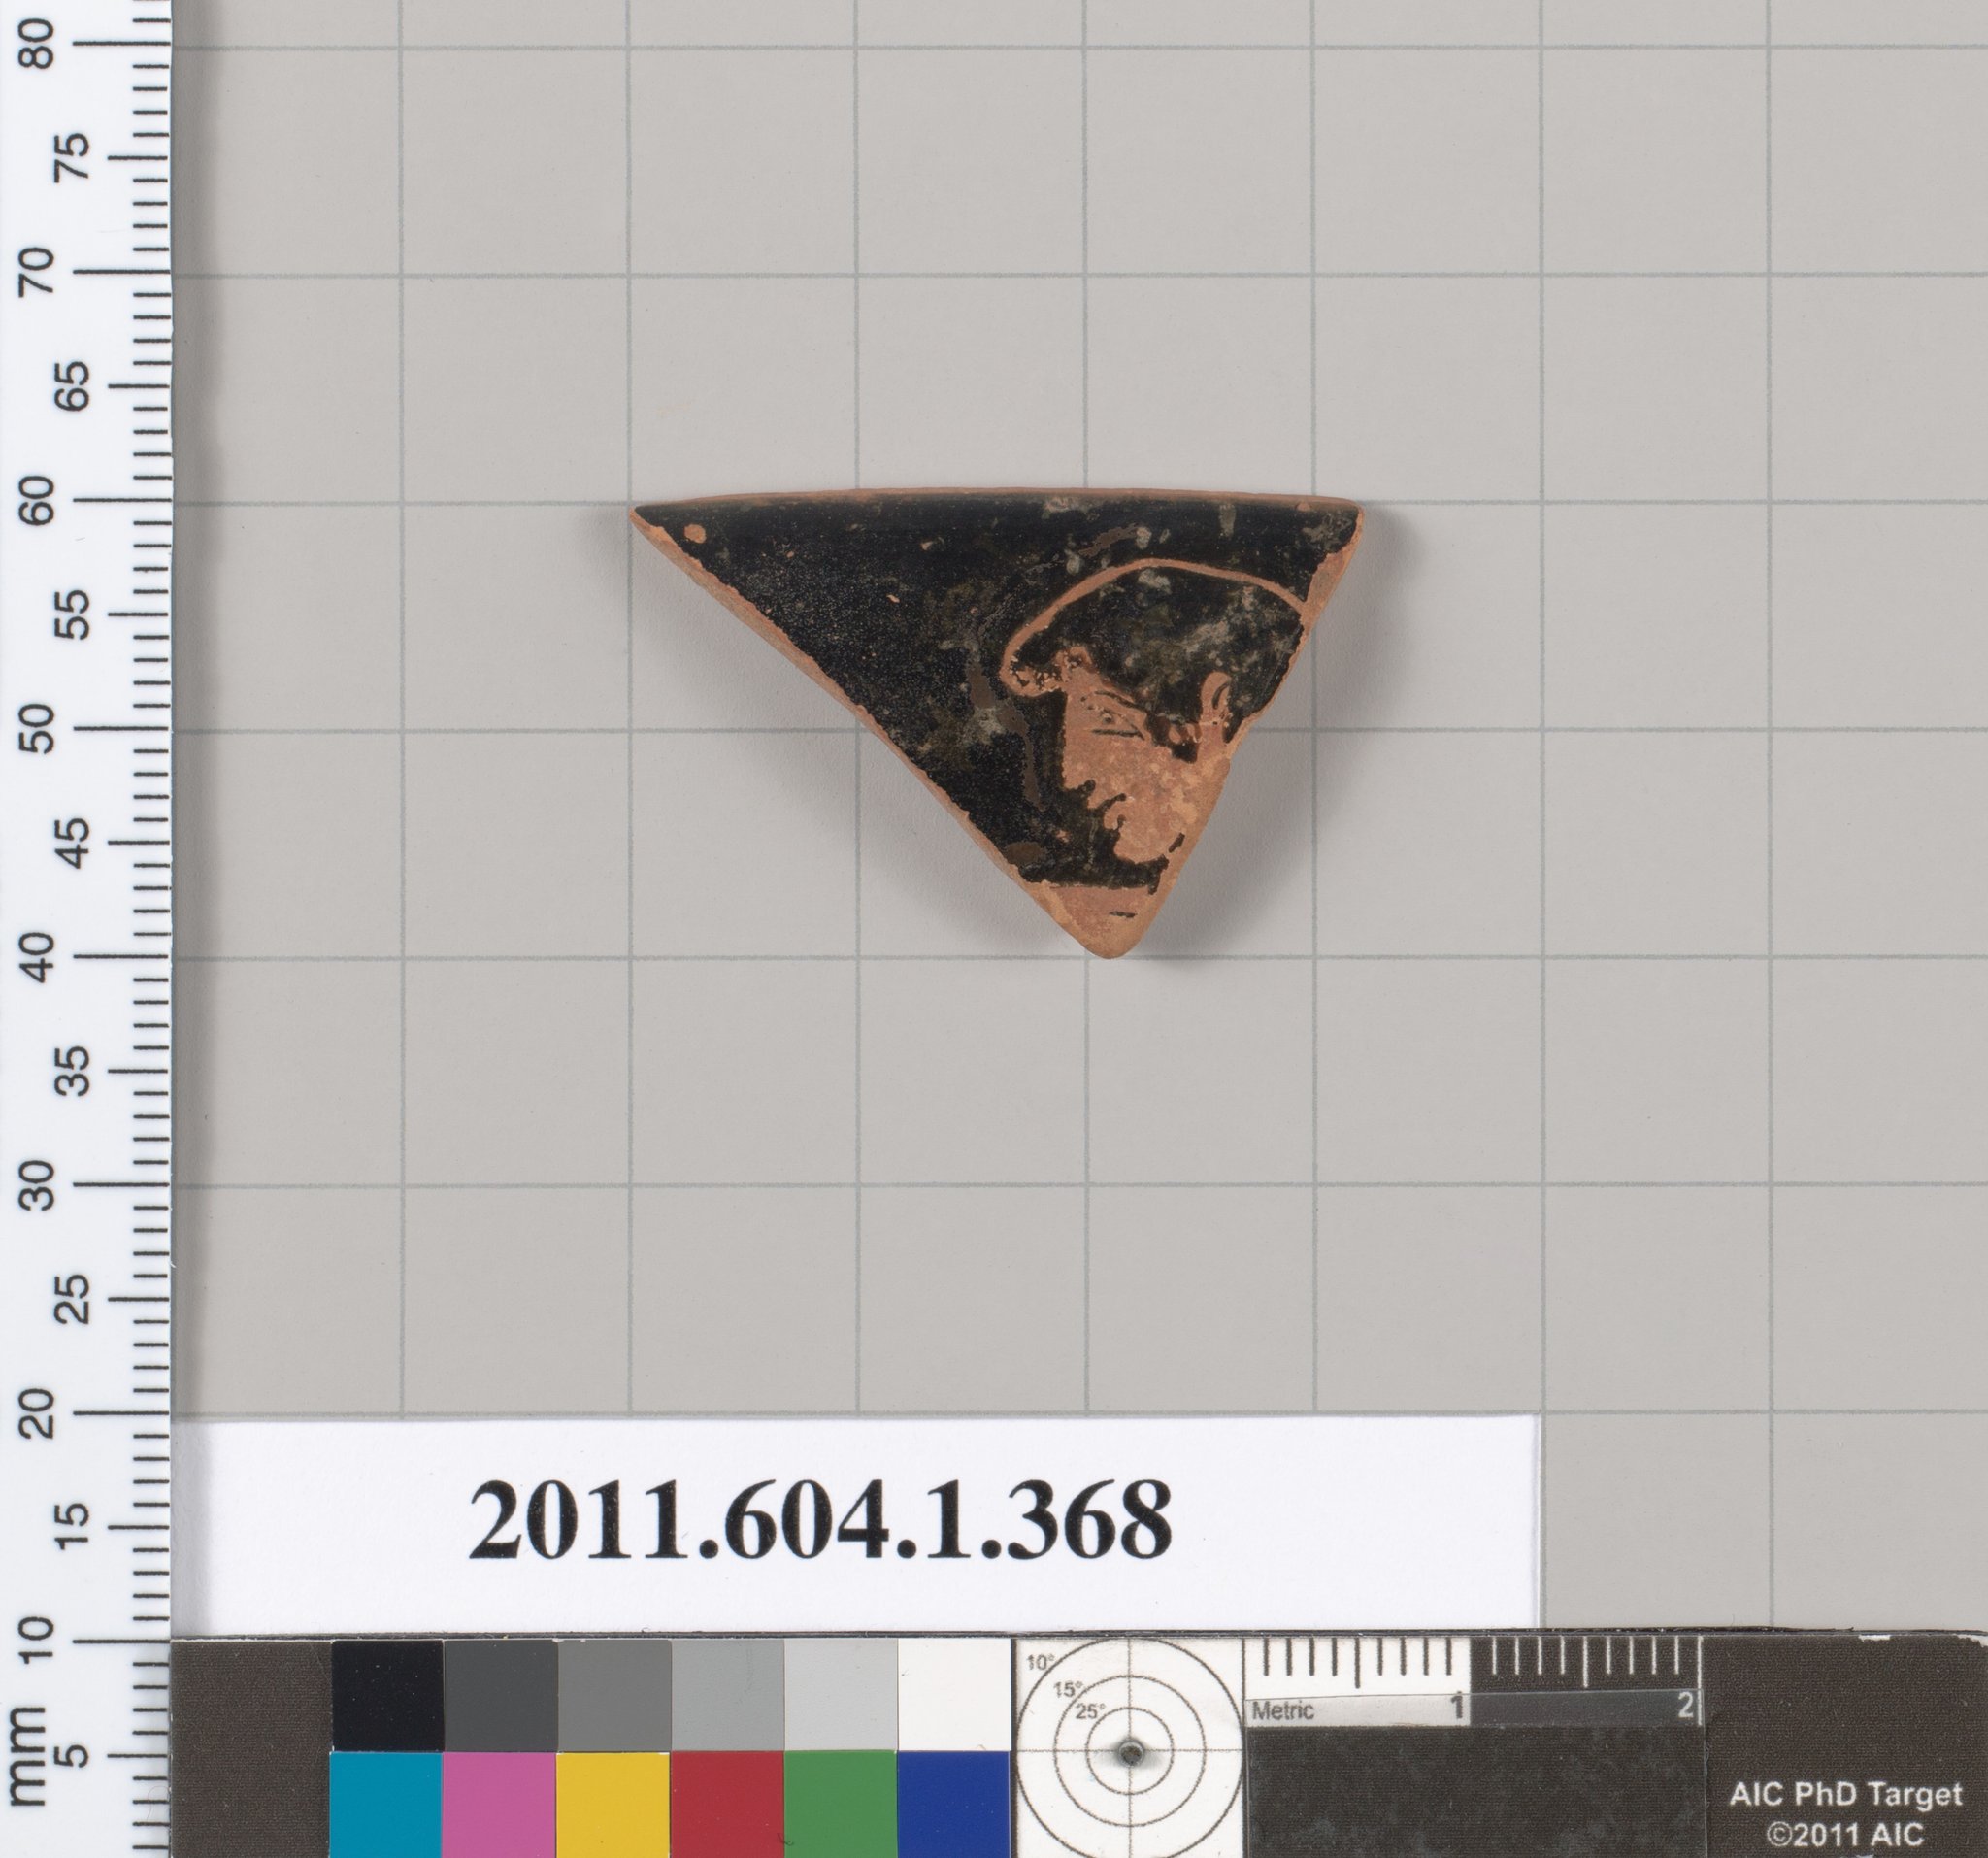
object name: kylix fragment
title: Terracotta rim fragment of a kylix (drinking cup)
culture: greek, attic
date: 467-435 BCE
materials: terracotta